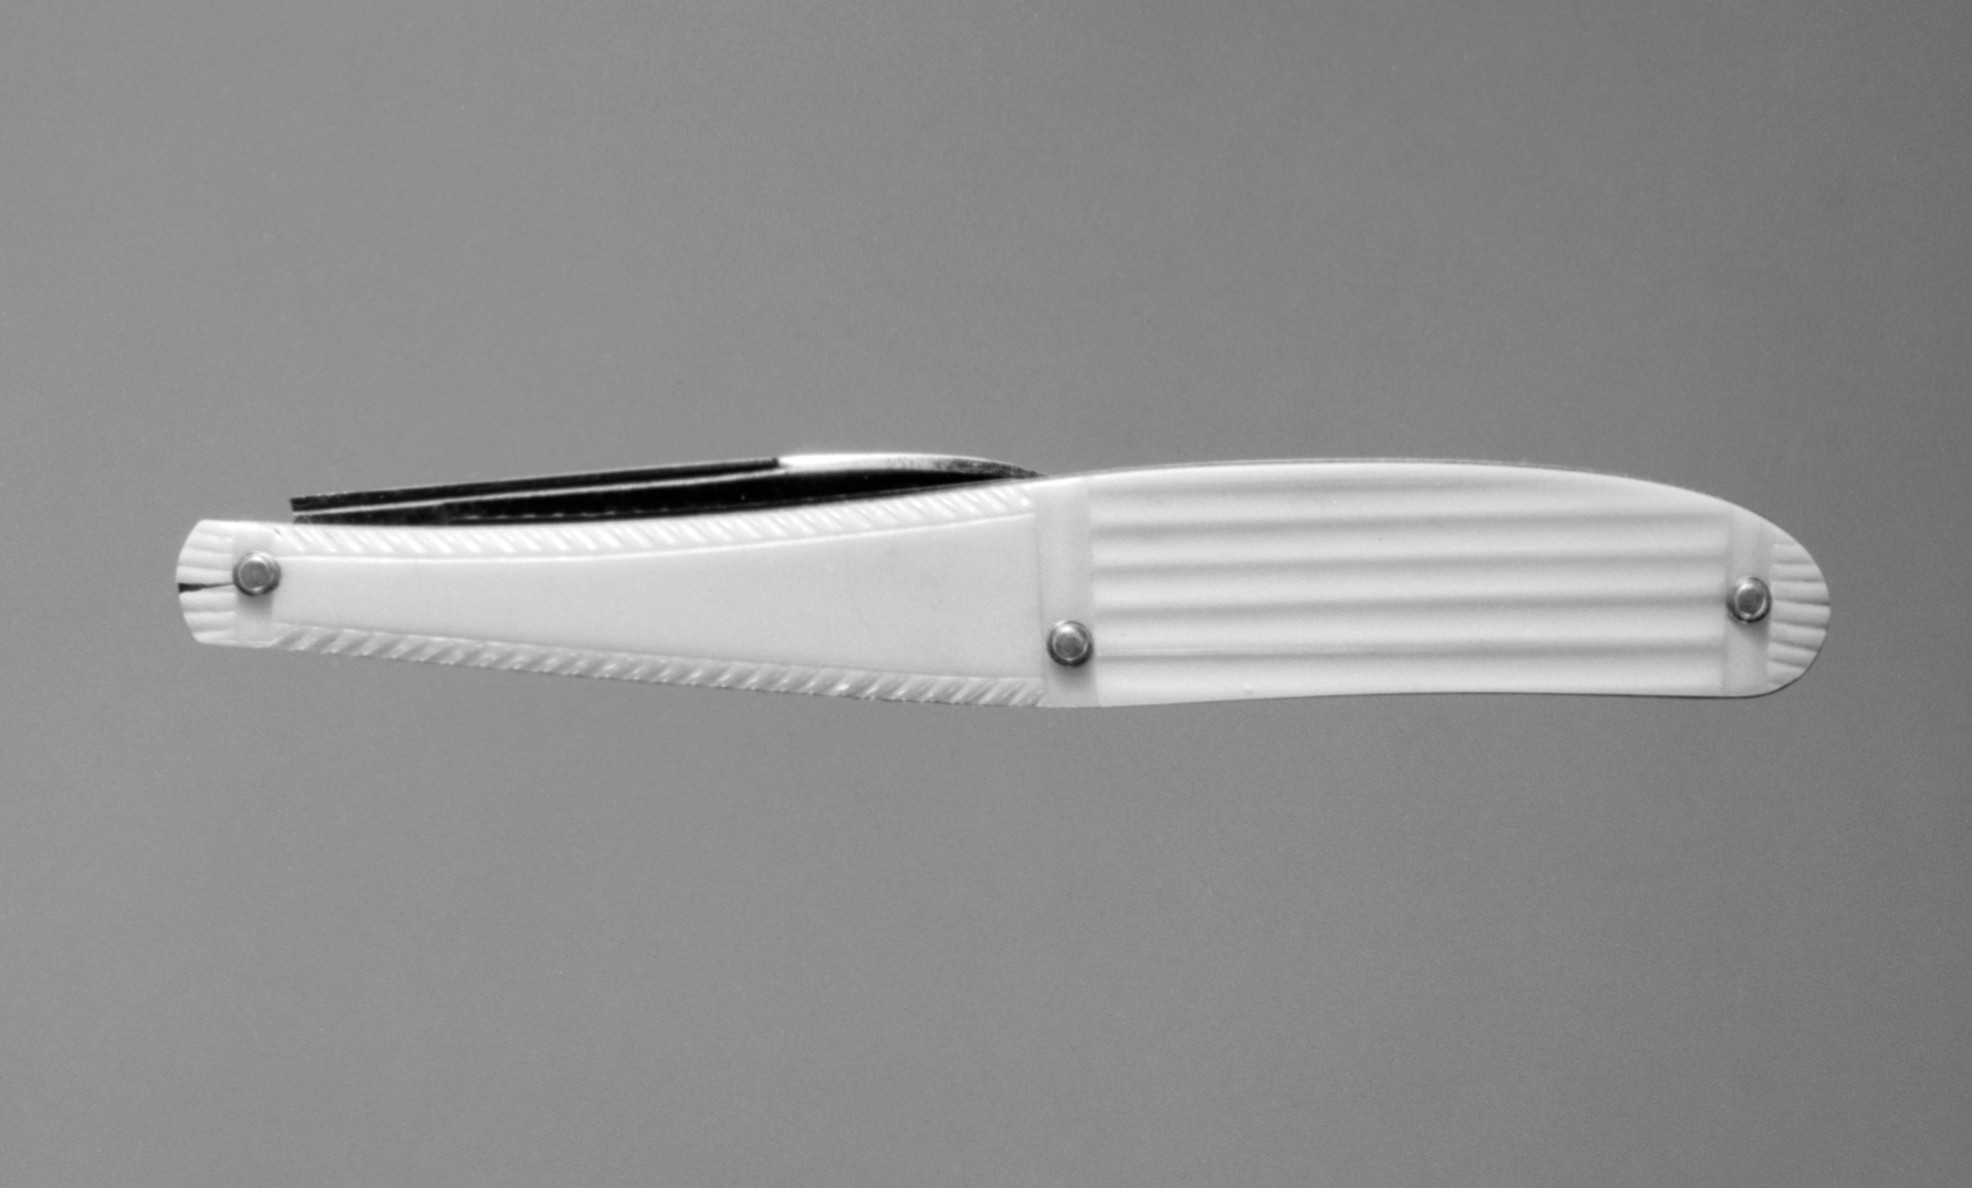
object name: pen knife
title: Pen knife (part of a set)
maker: joseph rodgers & sons, england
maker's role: maker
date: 1848-1849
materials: ivory, steel